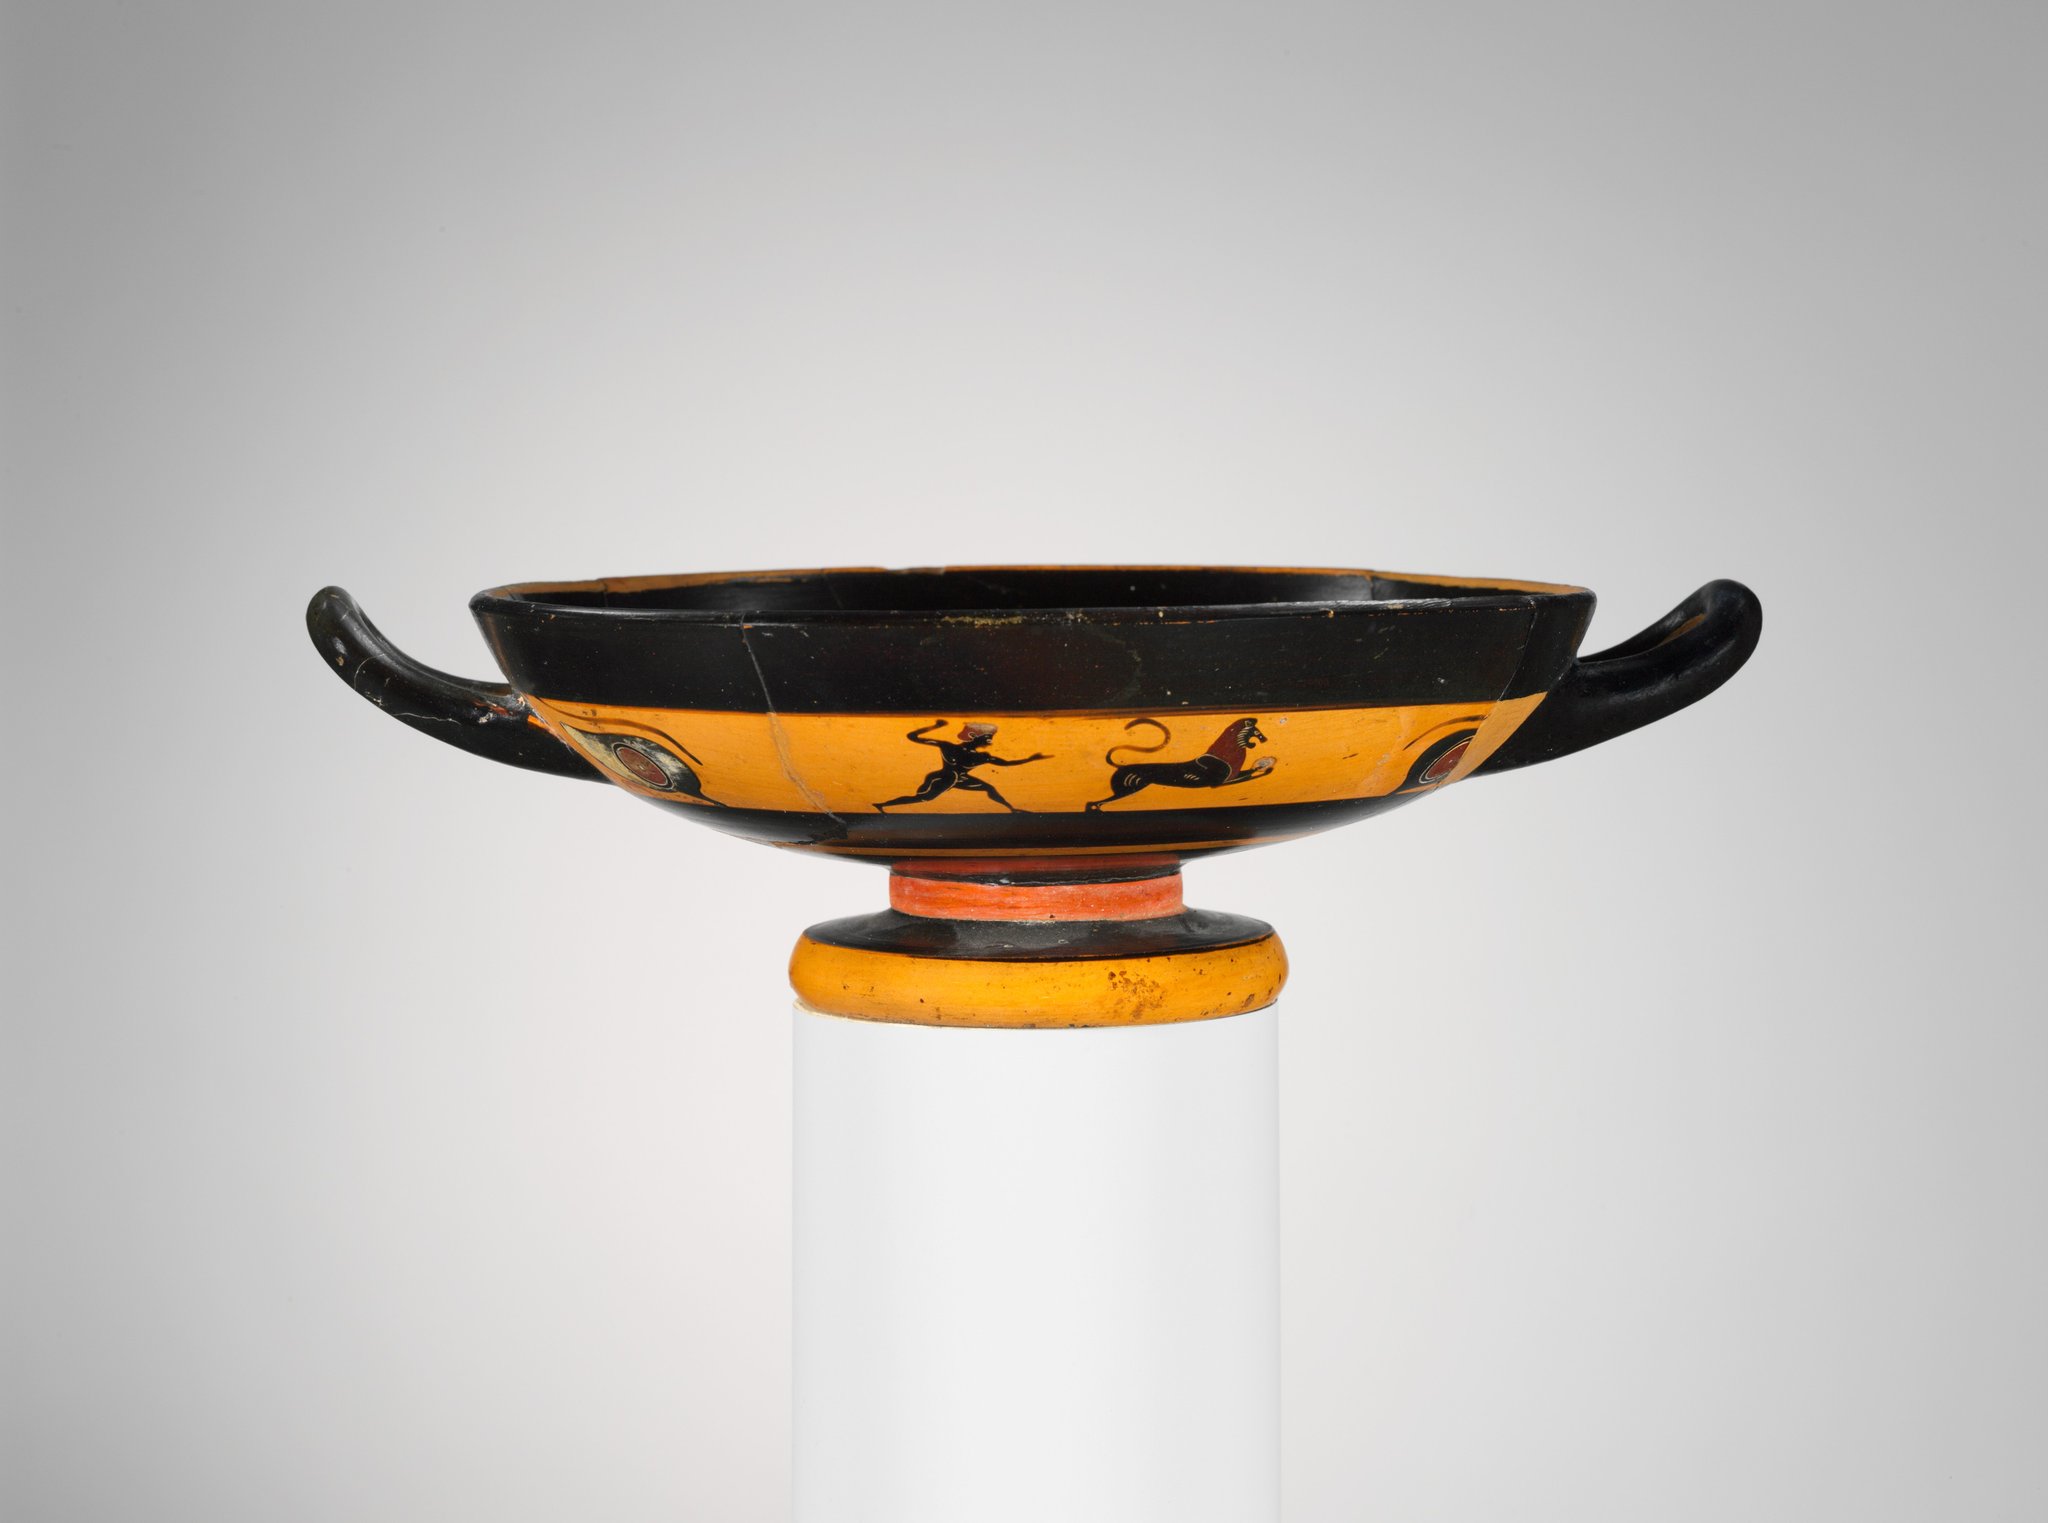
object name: kylix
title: Terracotta kylix (drinking cup)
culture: greek, attic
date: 535-500 BCE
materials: terracotta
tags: male nudes,lions